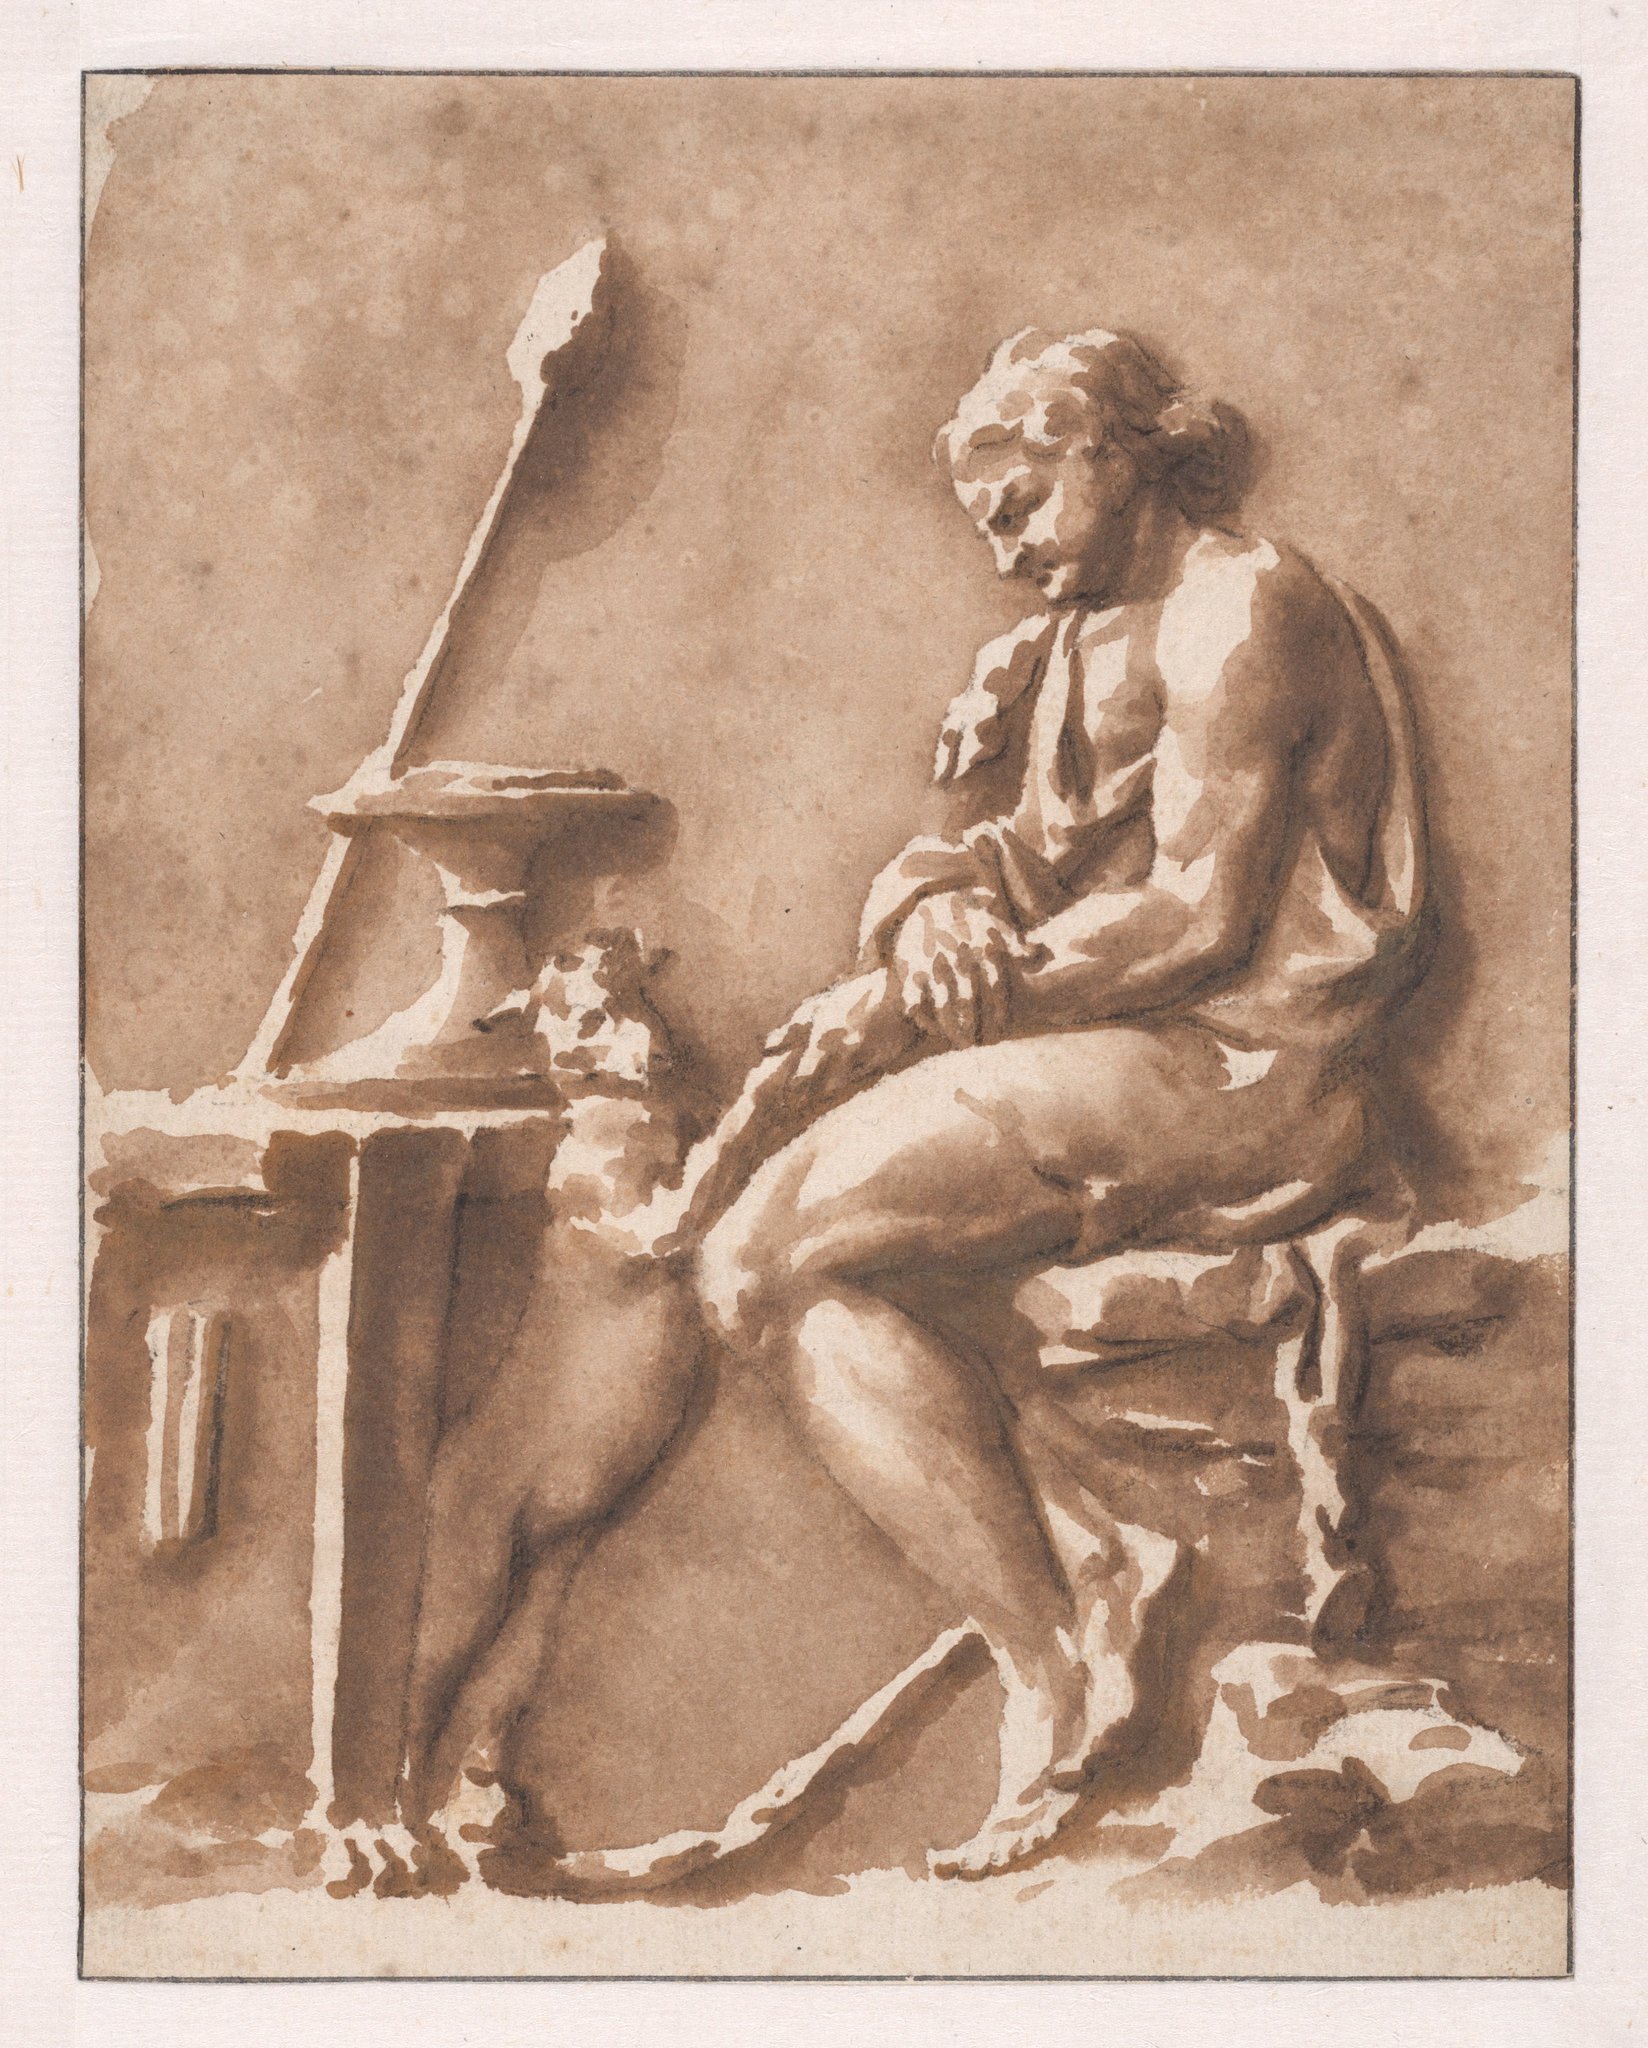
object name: drawing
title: Copy of an Antique Bas Relief: Dionysus Seated by a Table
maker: jan de bisschop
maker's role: artist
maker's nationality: dutch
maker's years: 1628-1671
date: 1634-1666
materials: chalk, ink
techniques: brush, wash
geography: netherlands